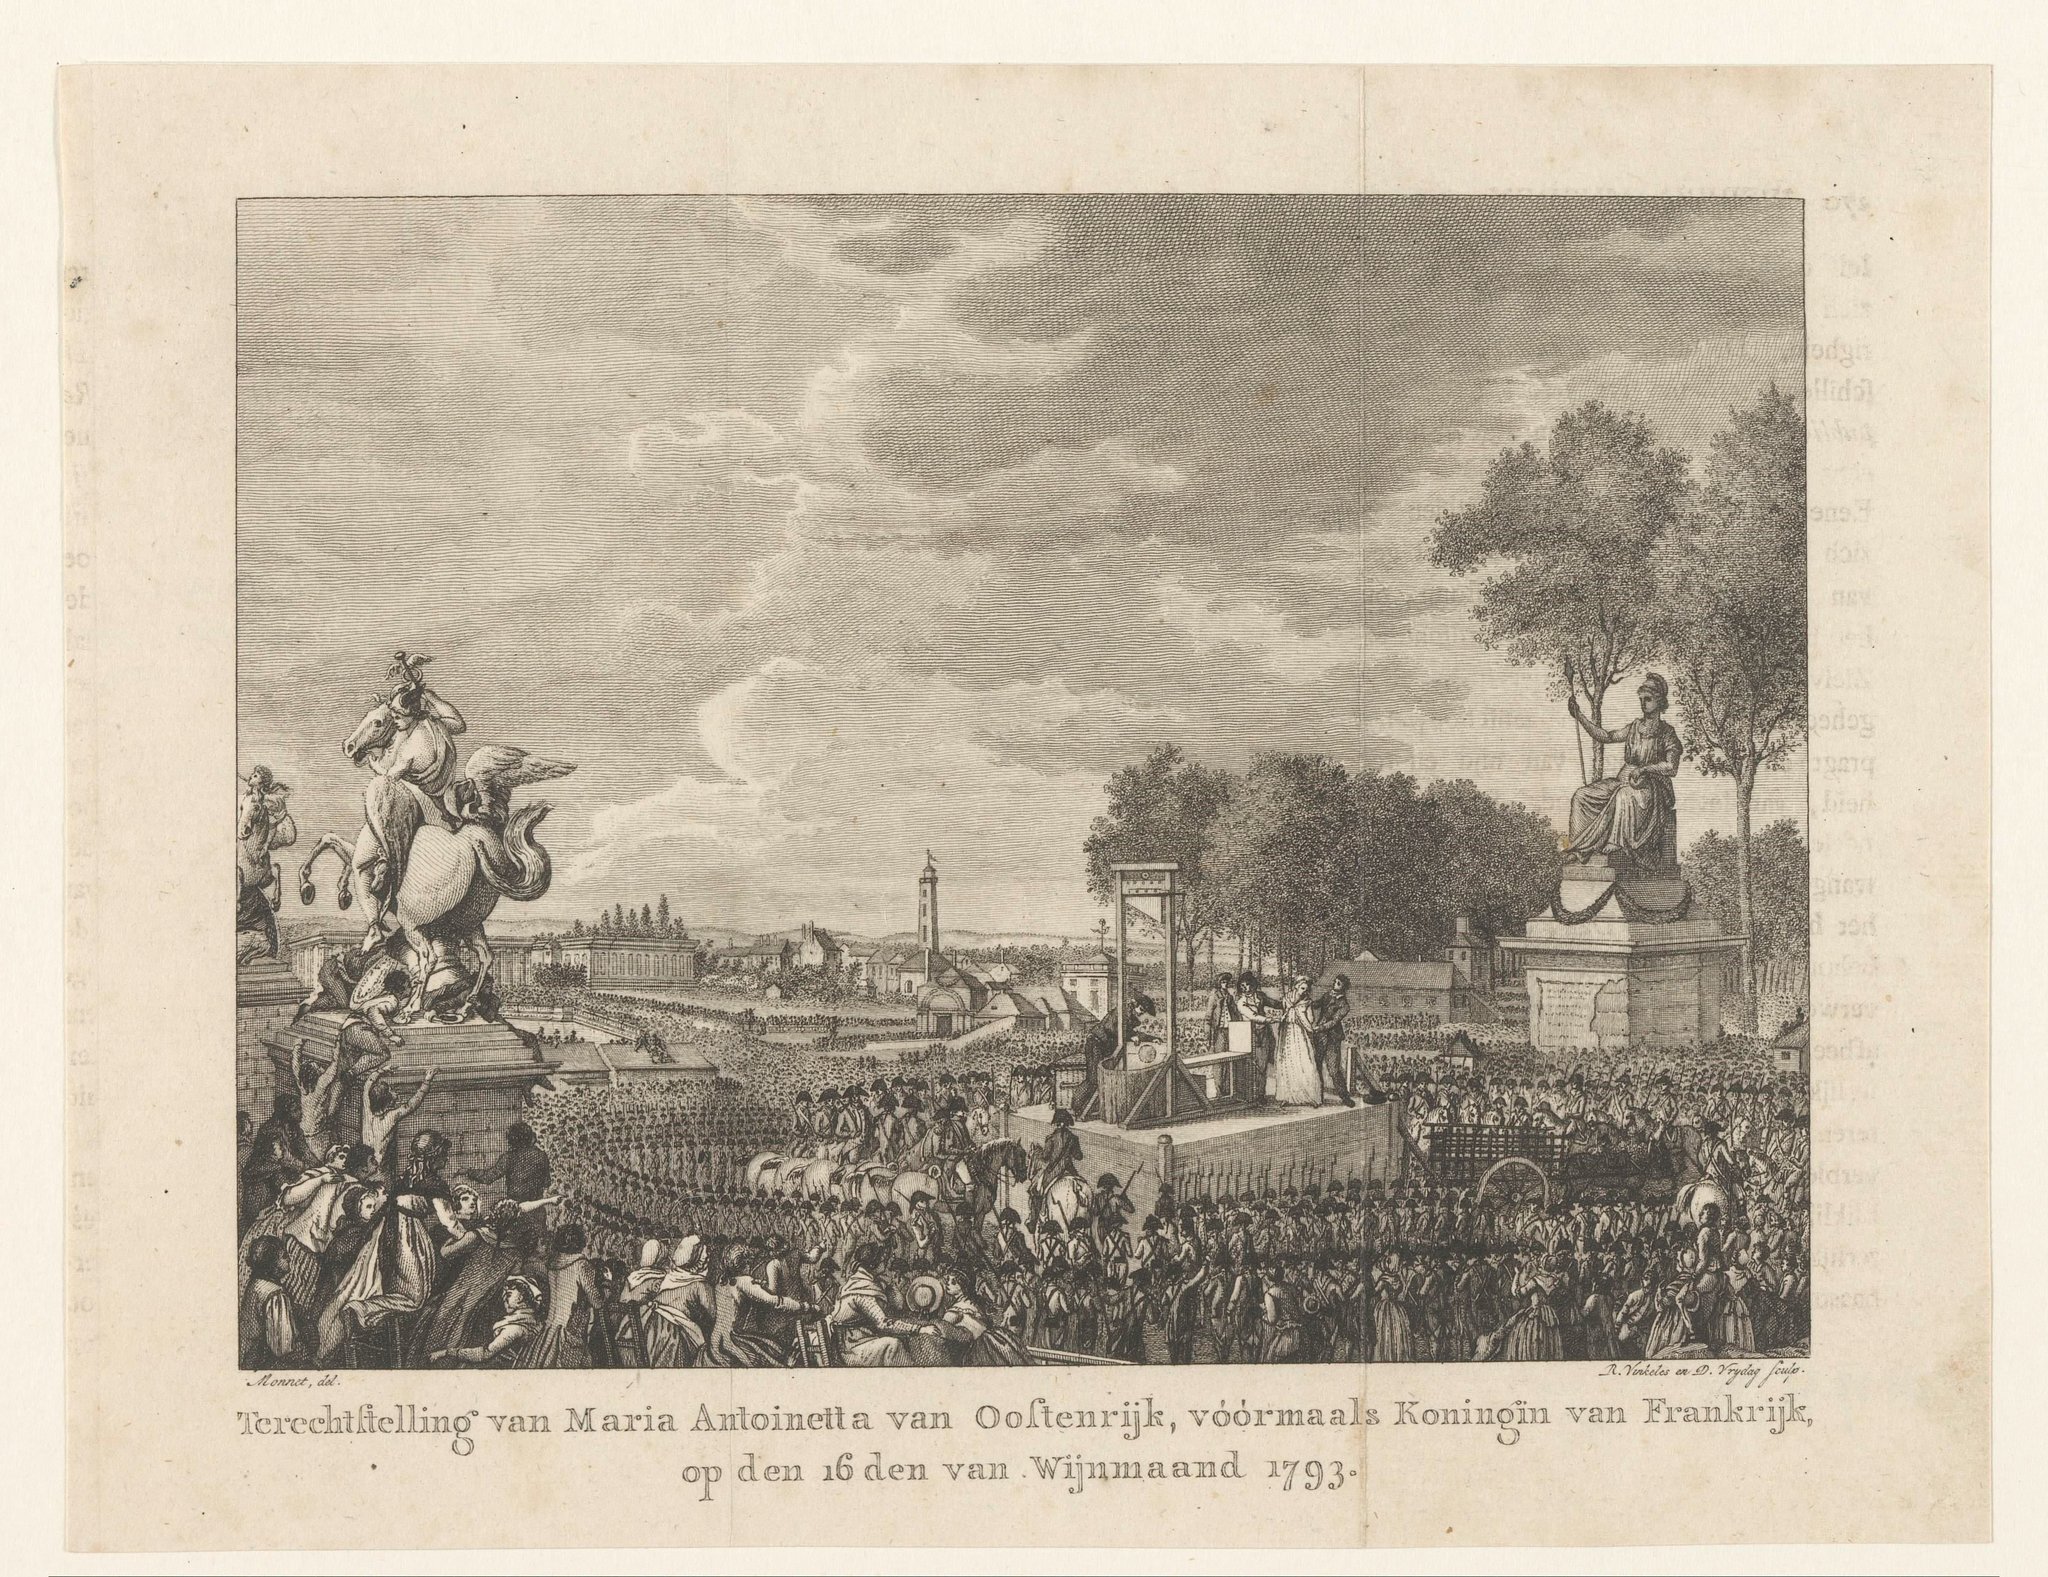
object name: print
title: Terechtstelling van Maria Antoinetta van Oostenrijk, voormaals Koningin van Frankrijk, op den 16den van Wijnmaand 1793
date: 1799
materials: paper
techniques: engraving, etching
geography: netherlands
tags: vienna, paris, marie antoinette, violent death ~ beheading by guillotine, on the scaffold or place of execution, (person under sentence of death) on the way to the scaffold or place of execution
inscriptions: collector's mark: Lugt 2228, collector's mark: Lugt 2760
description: Terechtstelling van Marie Antoinette, koningin van Frankrijk, op 16 oktober 1793. Het schavot met de guillotine temidden van menigte mensen.